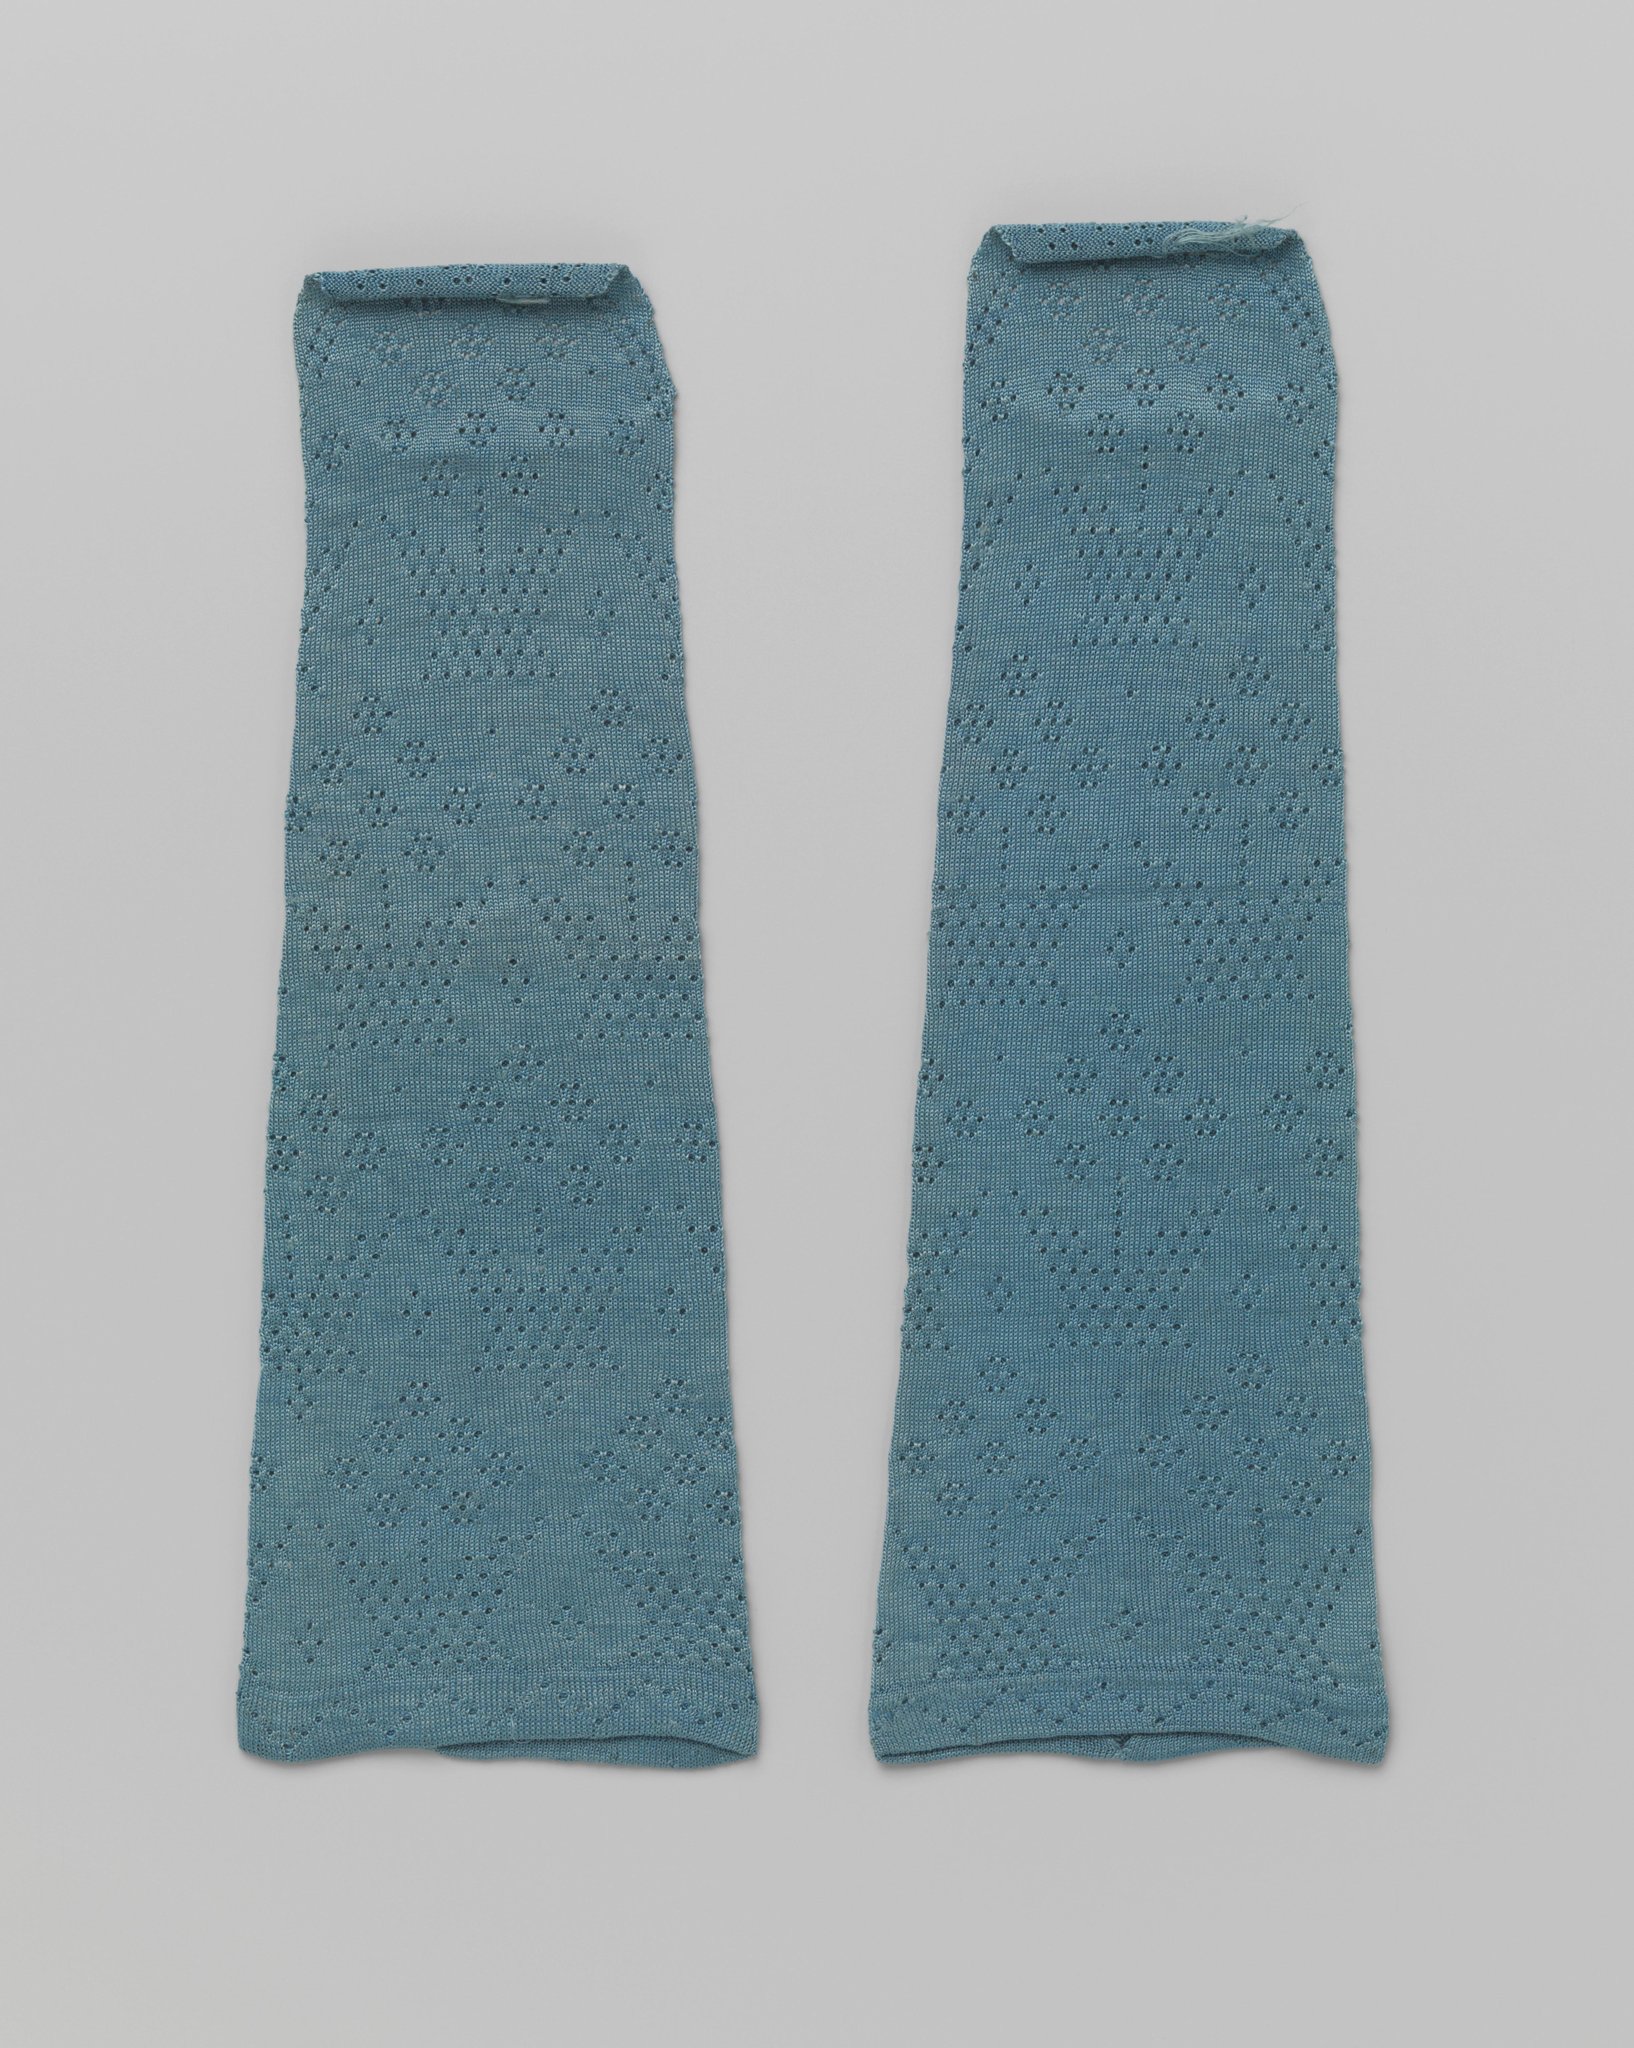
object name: mitt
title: Mitaine van blauwe zijde, open breiwerk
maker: Anonymous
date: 1750-1780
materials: silk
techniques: embroidery, knitting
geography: zaanstreek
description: Paar mitaines van open gebreide blauwe zijde. Model: Vingerloos. Met één naad. Afgeronde, bij het breien in de vorm afgekante, punt die over de handrug valt.Versiering: Grote, à-jour gebreide bloemenmanden, in verspringende rijen boven elkaar. Noord-Holland, de zaanstreek. Toestand: Gaaf van kleur.